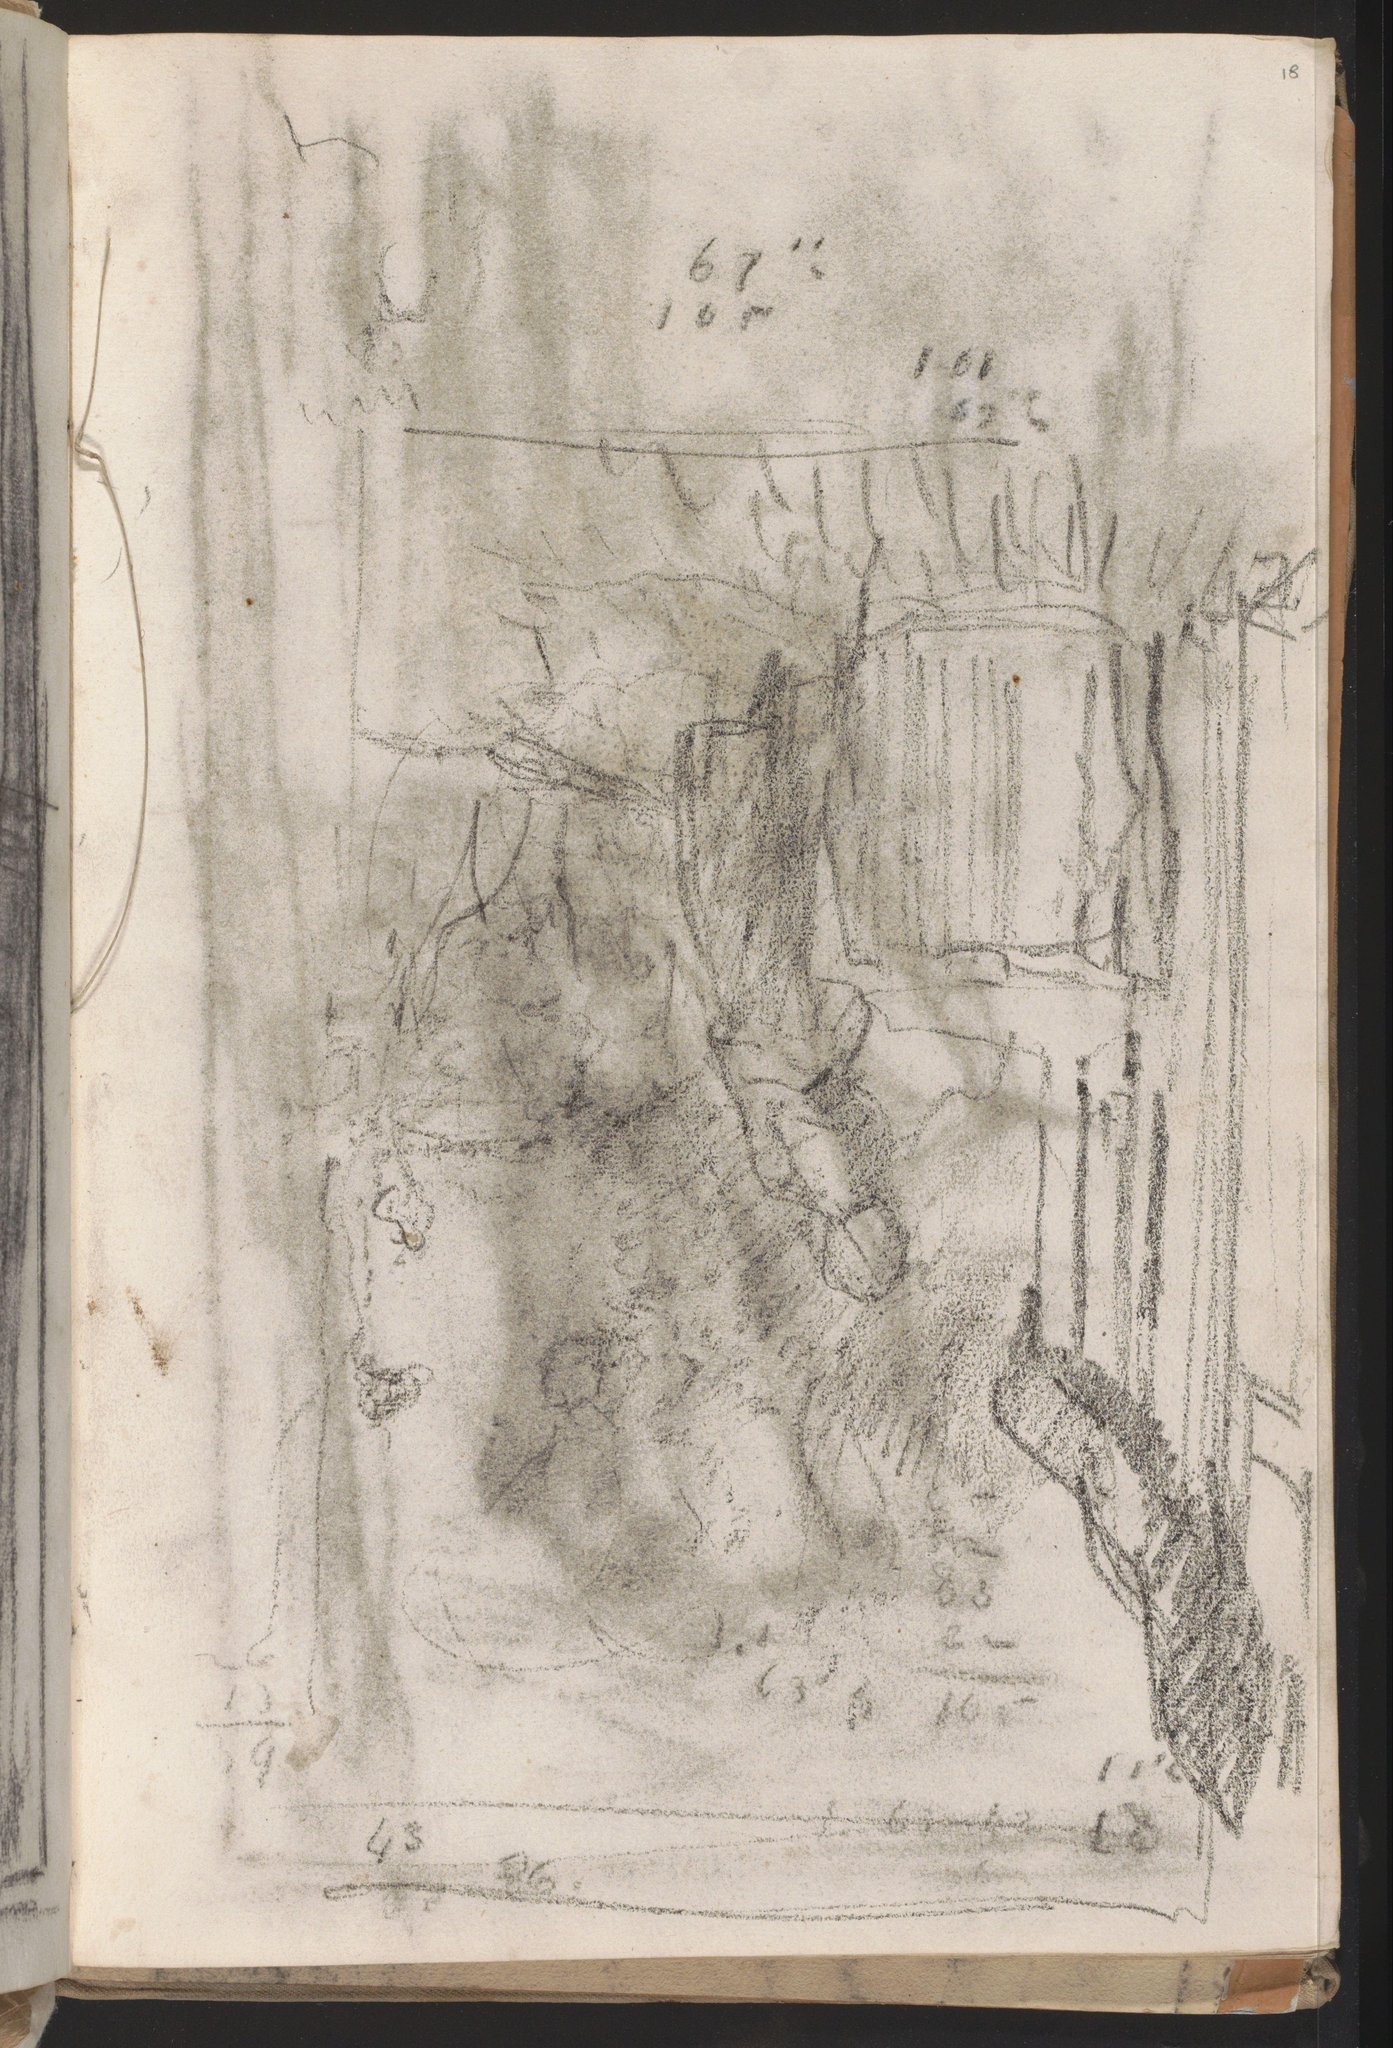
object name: sketchbook leaf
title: Figuurstudie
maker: albert neuhuys (1844-1914)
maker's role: draughtsman, painter, print maker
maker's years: 1844-1914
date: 1854-1914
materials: charcoal, paper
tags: anatomy (non-medical)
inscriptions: annotation: ‘[...]’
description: Blad 18 recto uit een schetsboek met 53 bladen.